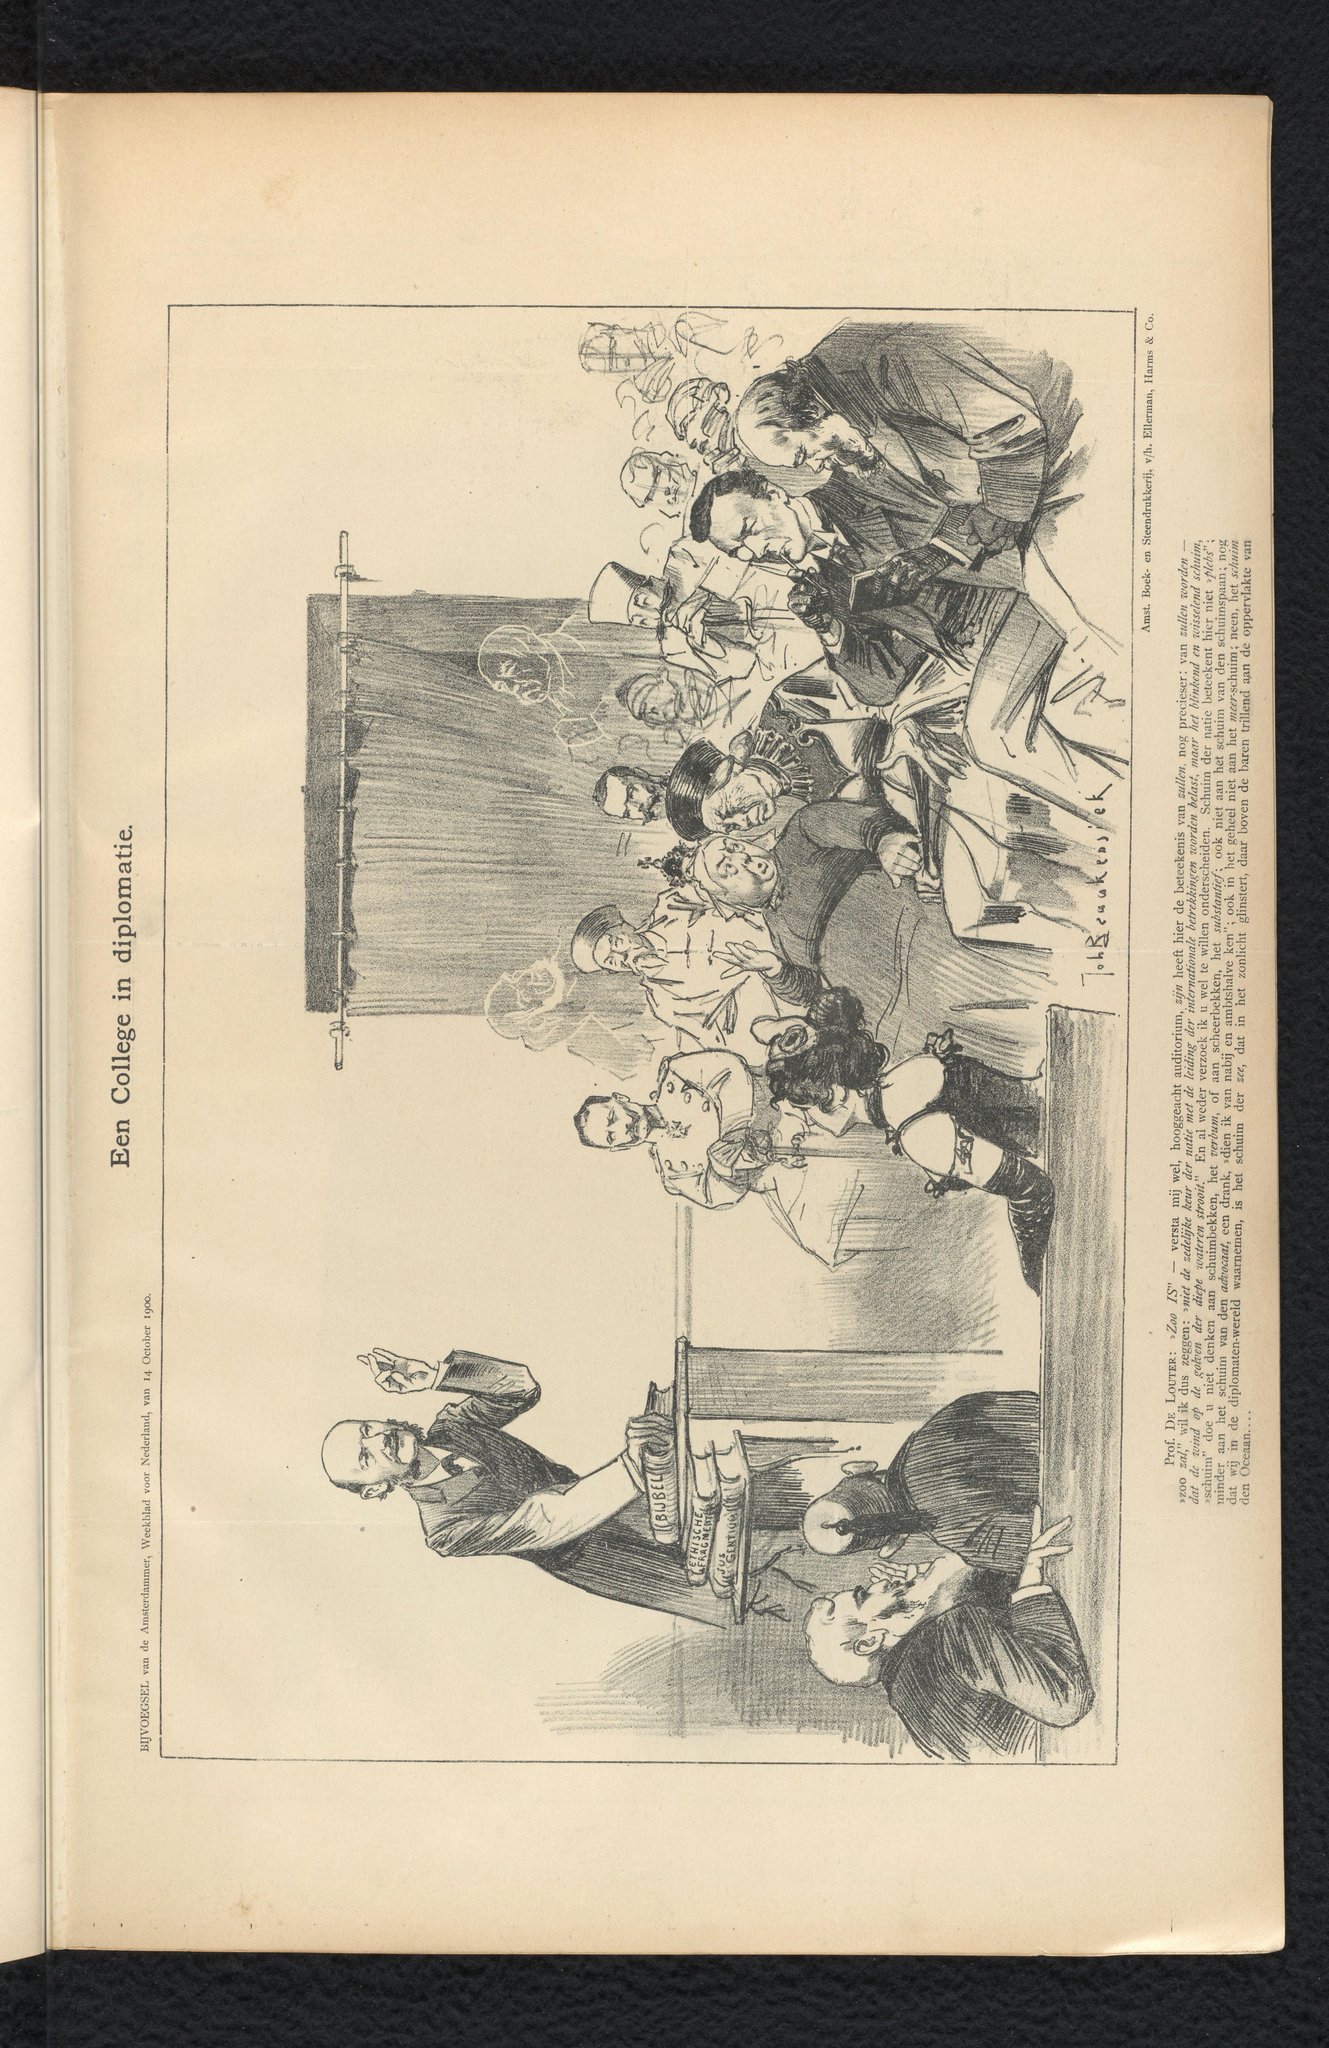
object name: cartoon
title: Een College in diplomatie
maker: johan braakensiek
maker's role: draughtsman, print maker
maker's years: 1858-1940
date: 1900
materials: paper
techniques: lithograph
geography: netherlands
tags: victoria (koningin van het verenigd koninkrijk en keizerin van india), wilhelm ii (keizer van duitsland), cixi (keizerin-regentes van china), personifications of countries, nations, states, districts, etc., spirit, ghost, professor, student, political caricatures and satires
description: Professor Jan de Louter houdt een college over diplomatie voor een publiek bestaande uit de grote mogendheden en regeringsleiders. Ook twee geesten onder de toehoorders, waarschijnlijk Gladstone en Bismarck.